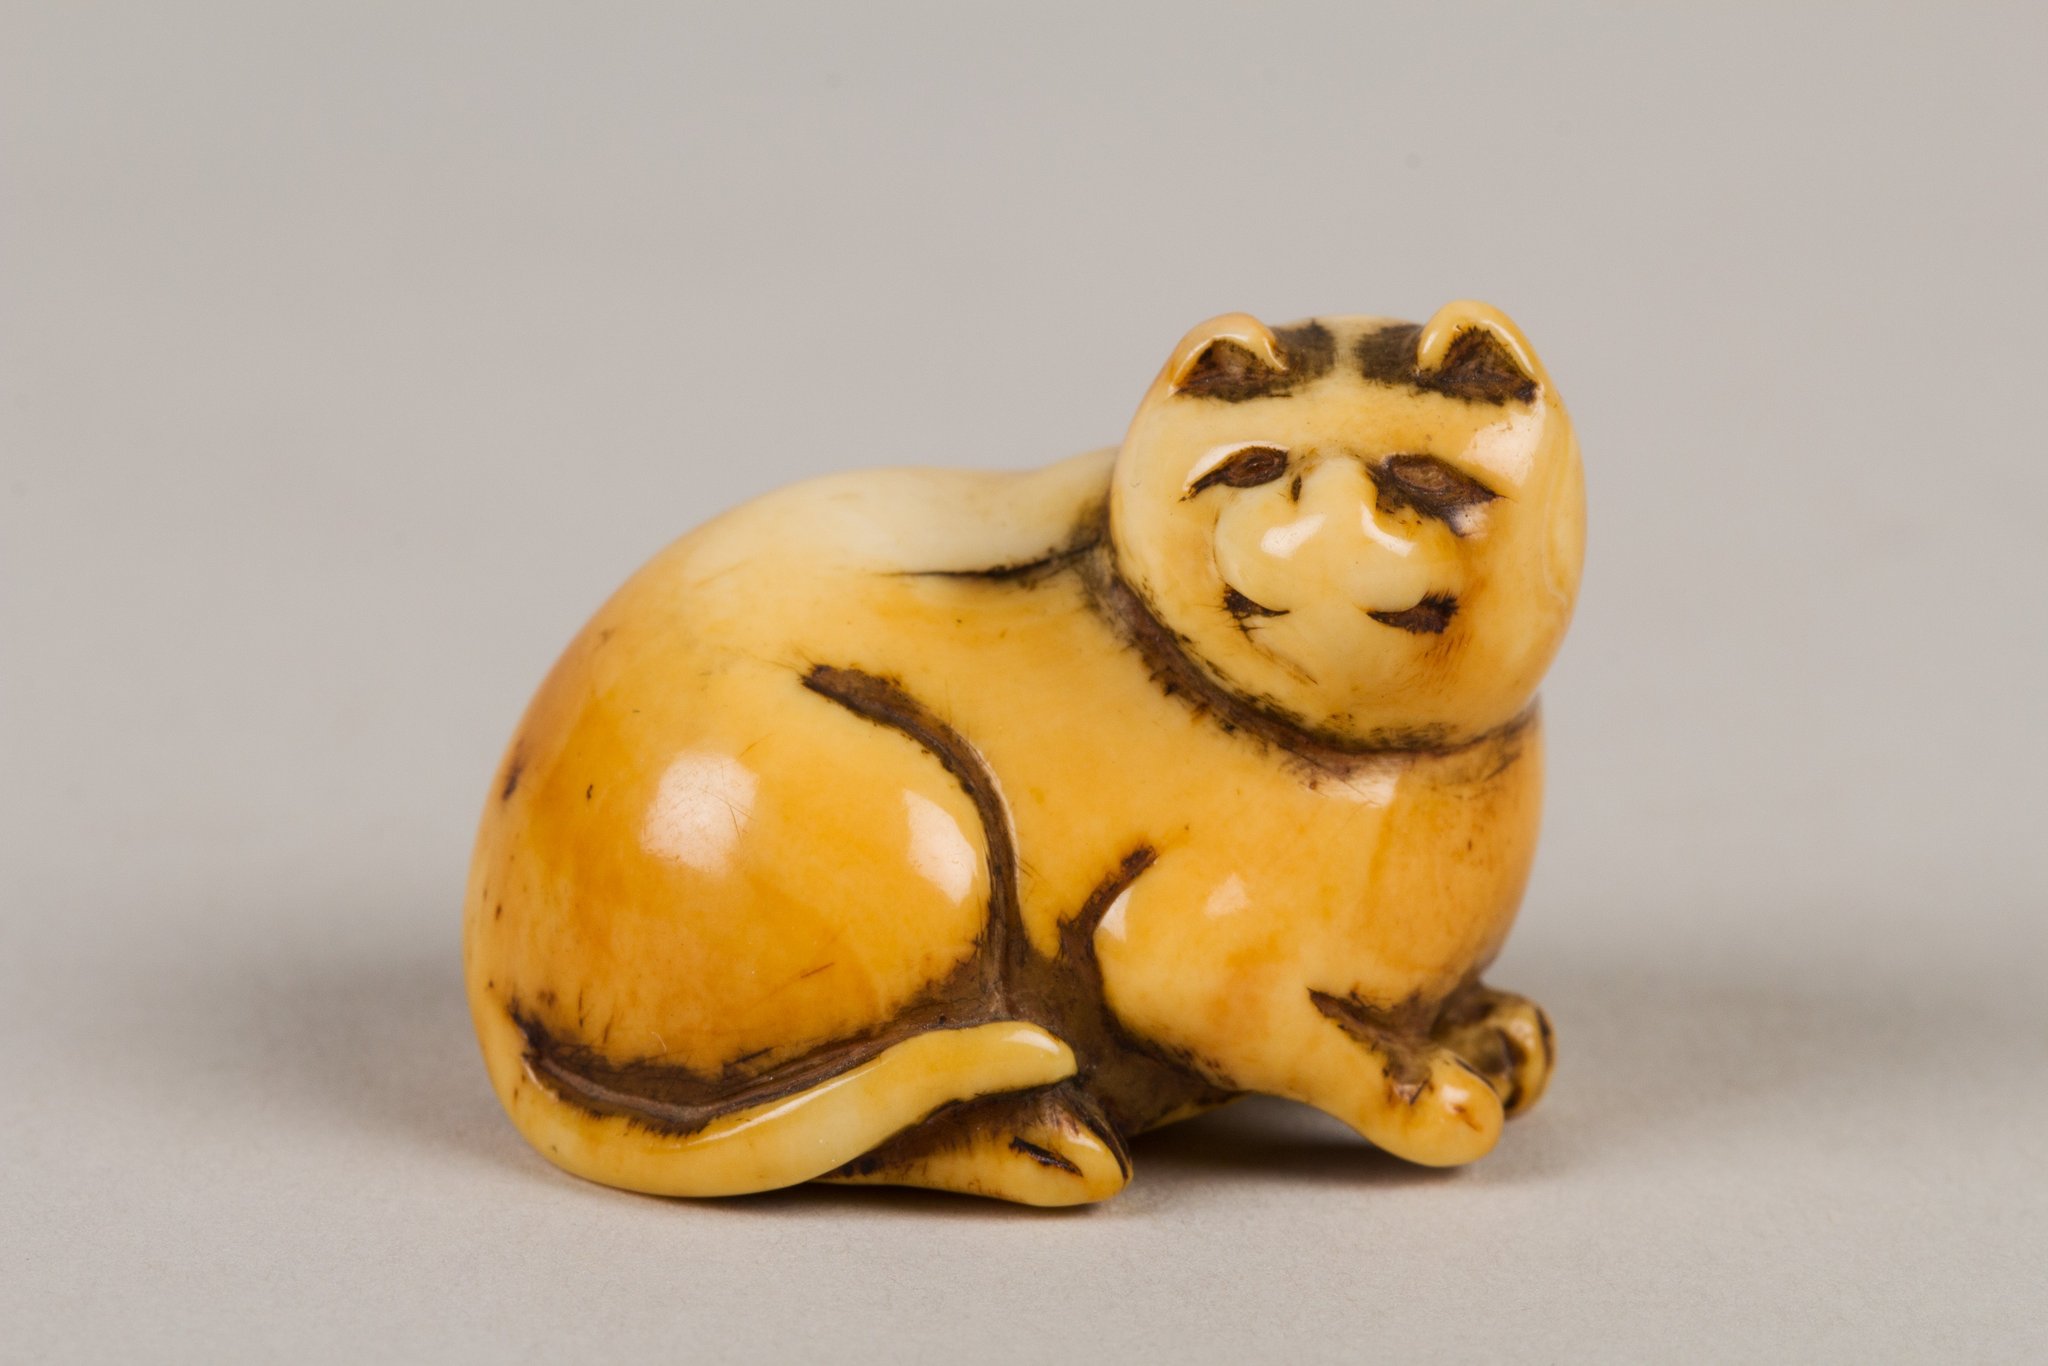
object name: netsuke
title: Netsuke of Cat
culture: japanese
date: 1801-1900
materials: ivory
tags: cats